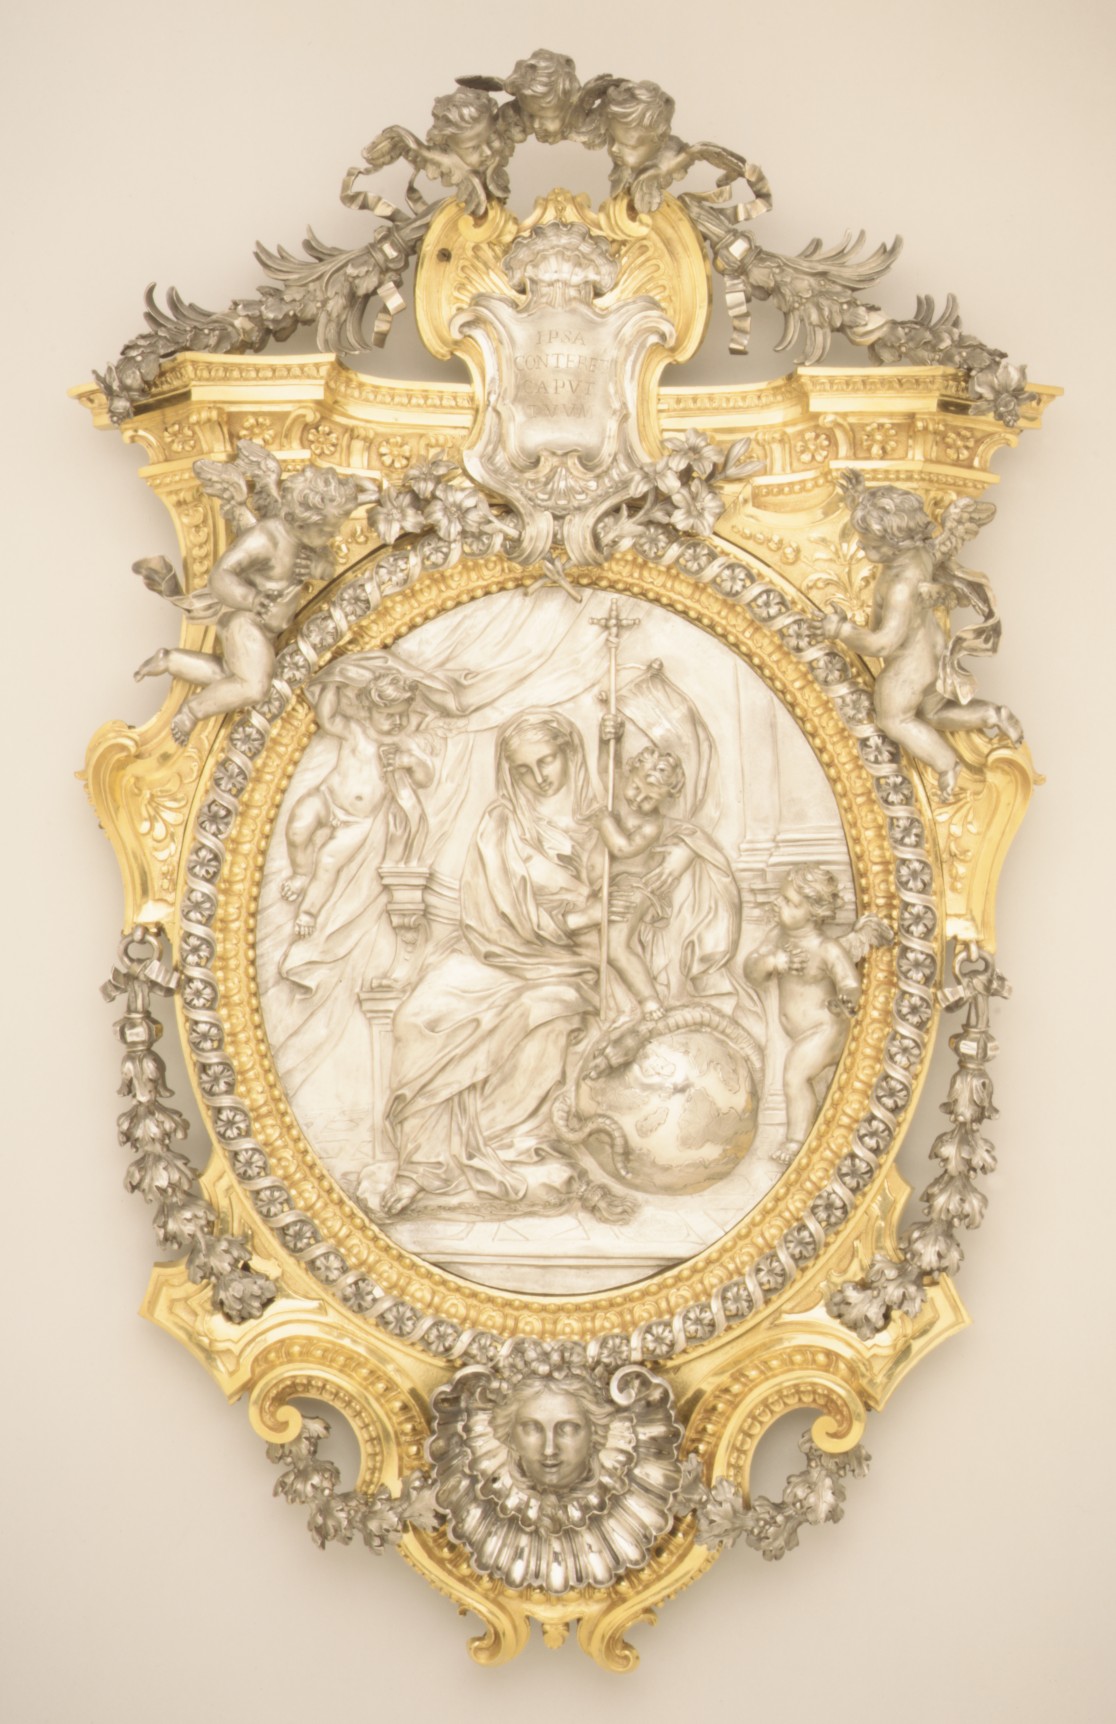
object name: relief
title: The Virgin and Child Triumphing over Evil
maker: francesco giardoni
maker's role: maker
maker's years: 1692-1757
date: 1731-1740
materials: gilt bronze, silver, wood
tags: flowers,angels,madonna and child,insignia